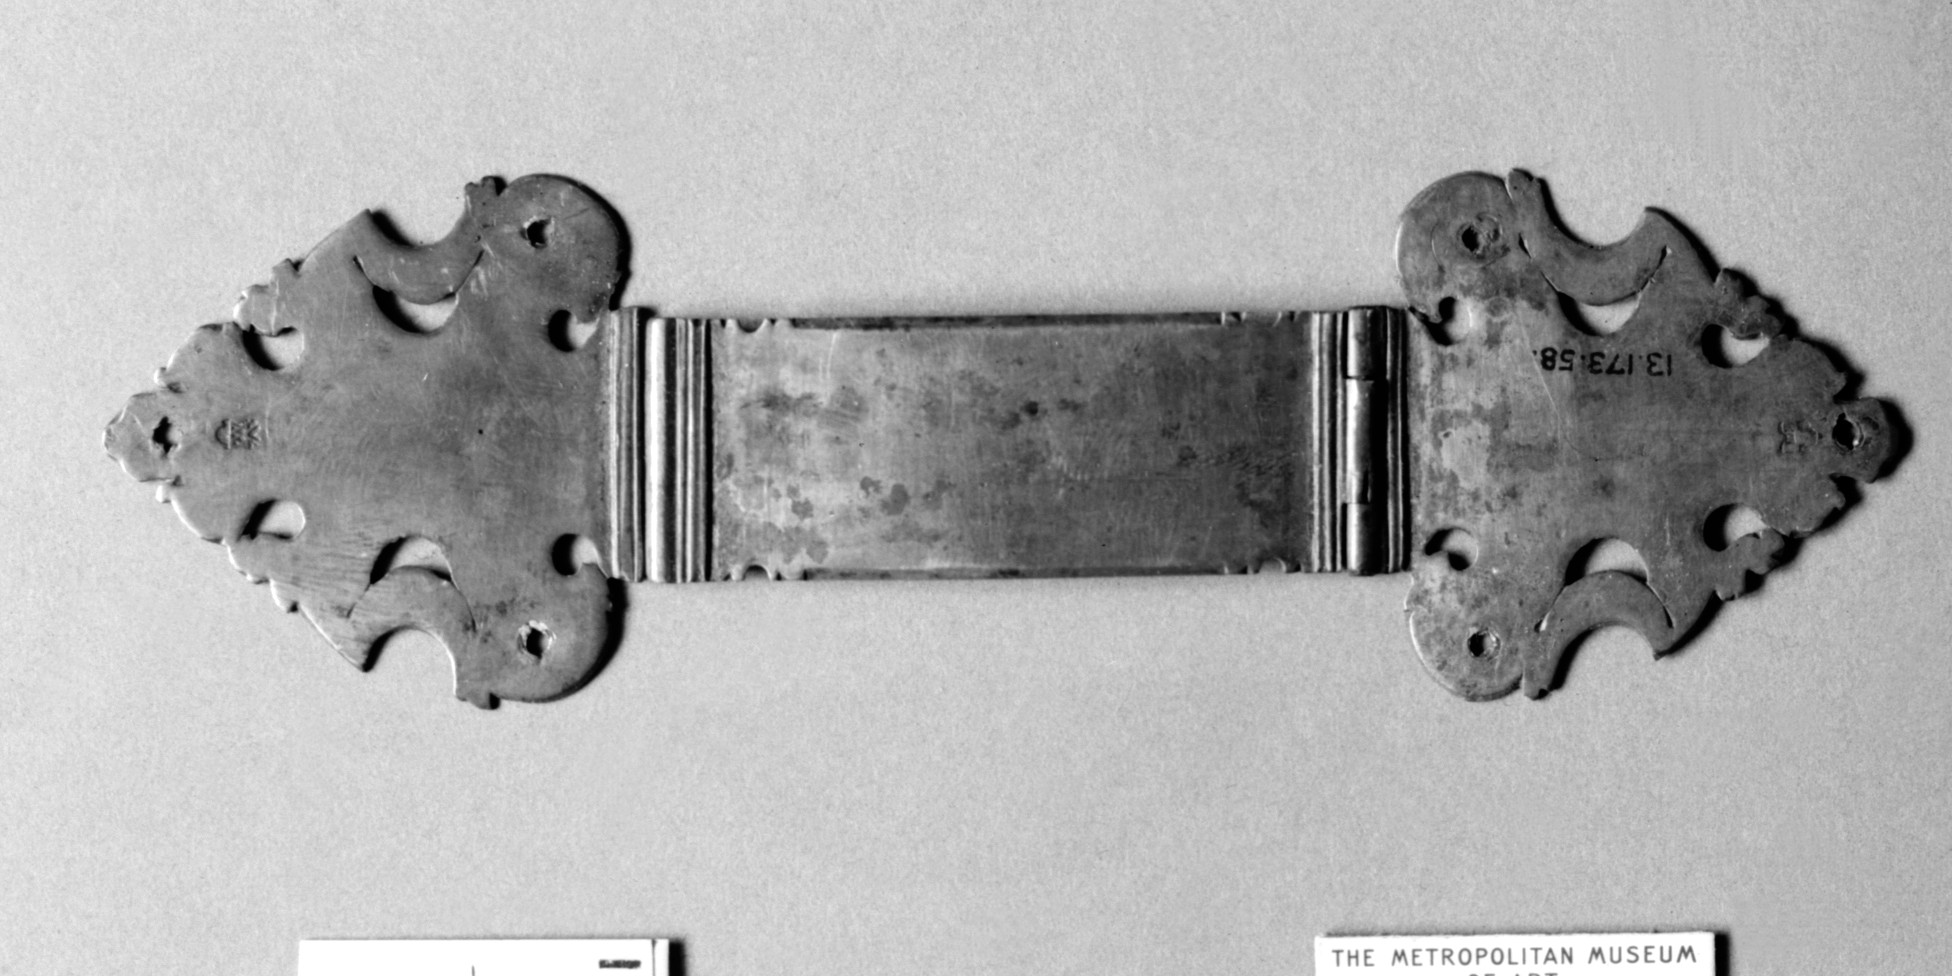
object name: book clasp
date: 1701-1800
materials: silver